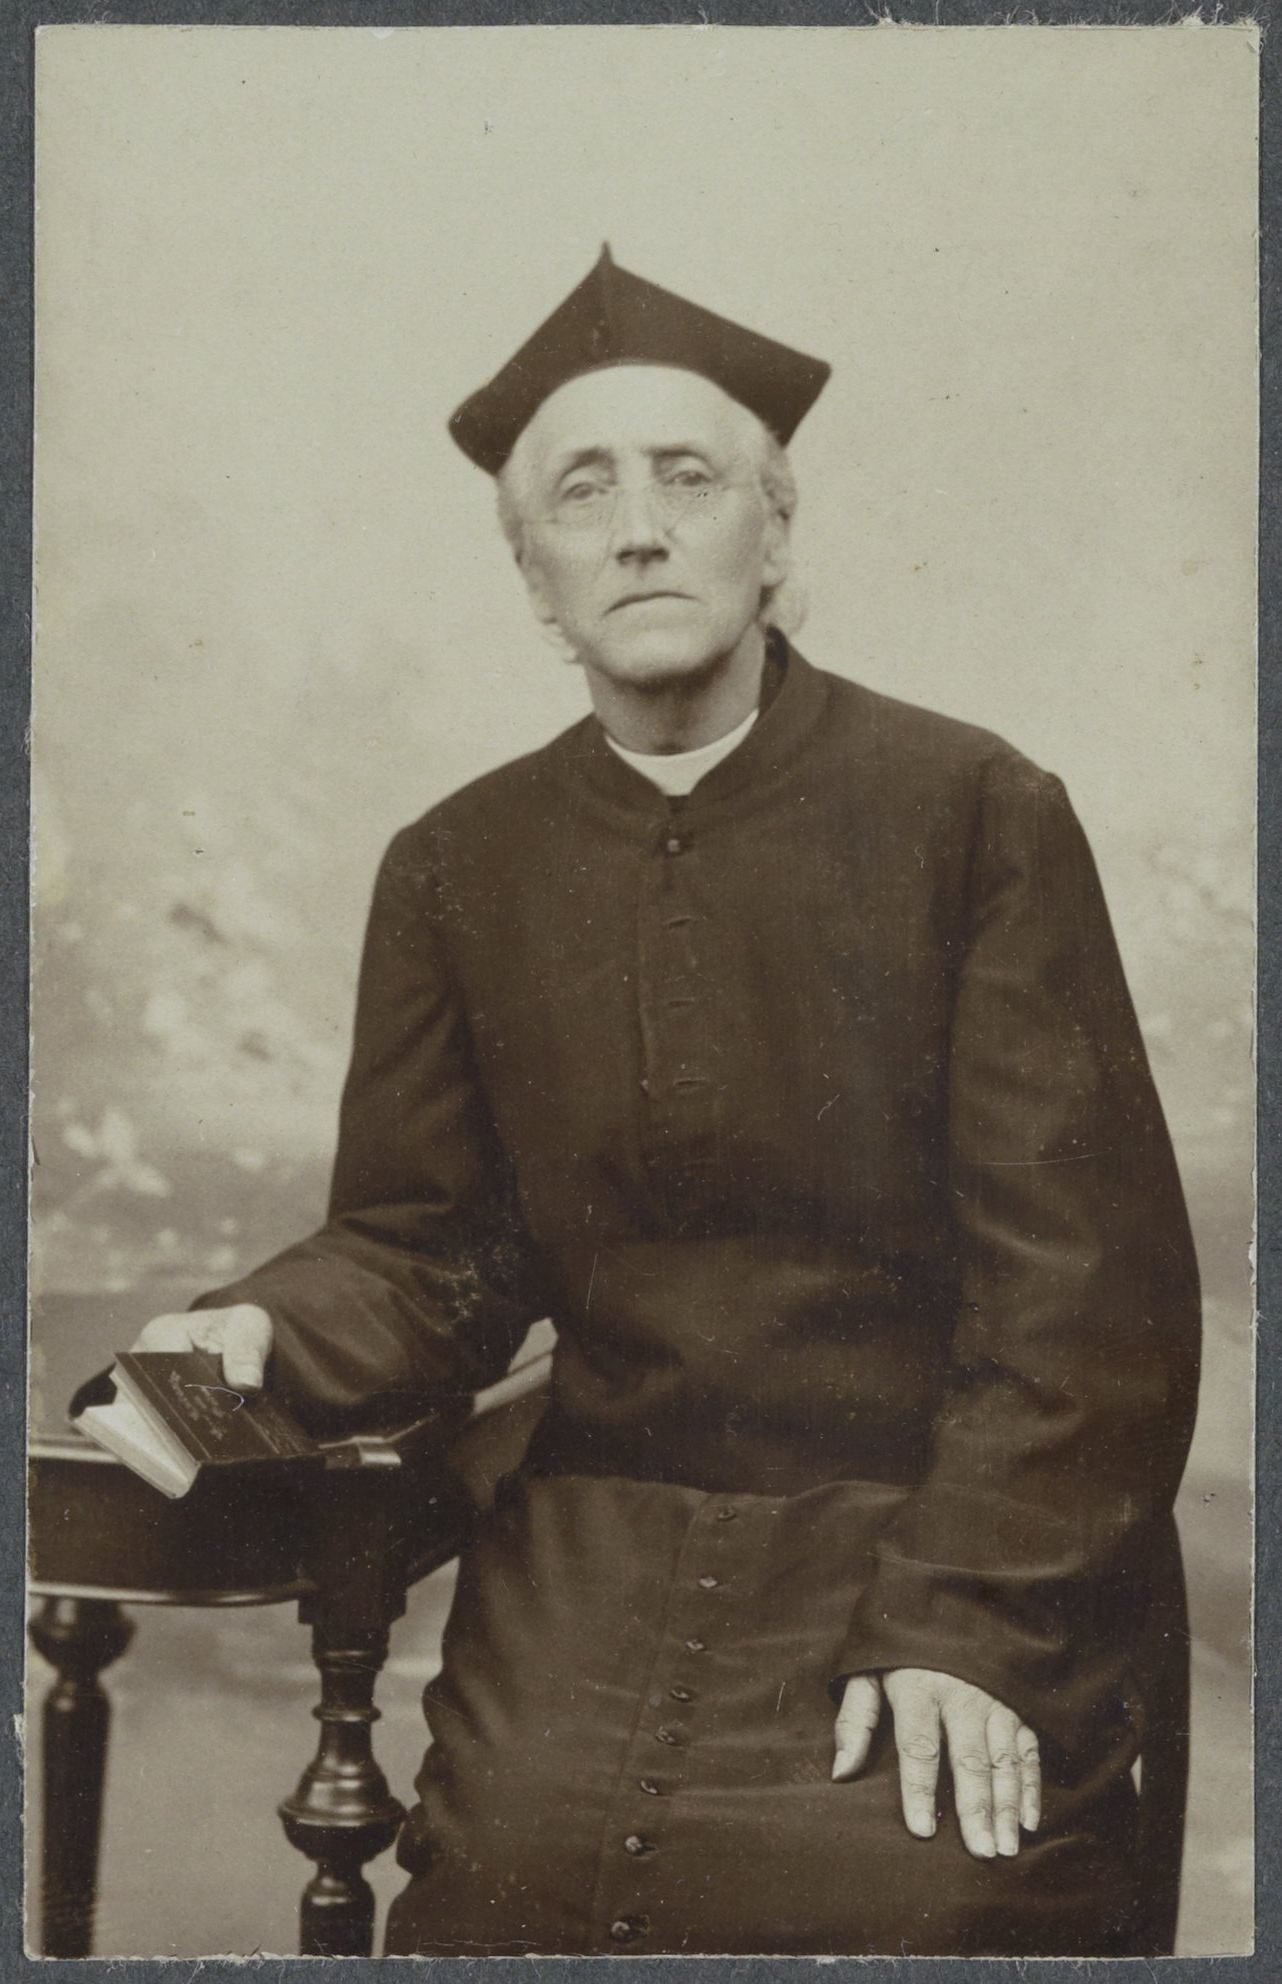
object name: photograph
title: Portret van een katholieke geestelijke, zittend in soutane met een boek in de hand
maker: Anonymous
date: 1920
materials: cardboard, paper, photographic support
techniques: collodion silver print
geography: netherlands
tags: liturgical vestments, canonicals, priest (roman catholic), adult man, historical persons, head-gear: cap, netherlands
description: Onderdeel van Fotoalbum met portretten vervaardigd door Nederlandse studio's waaronder automaatfoto's.